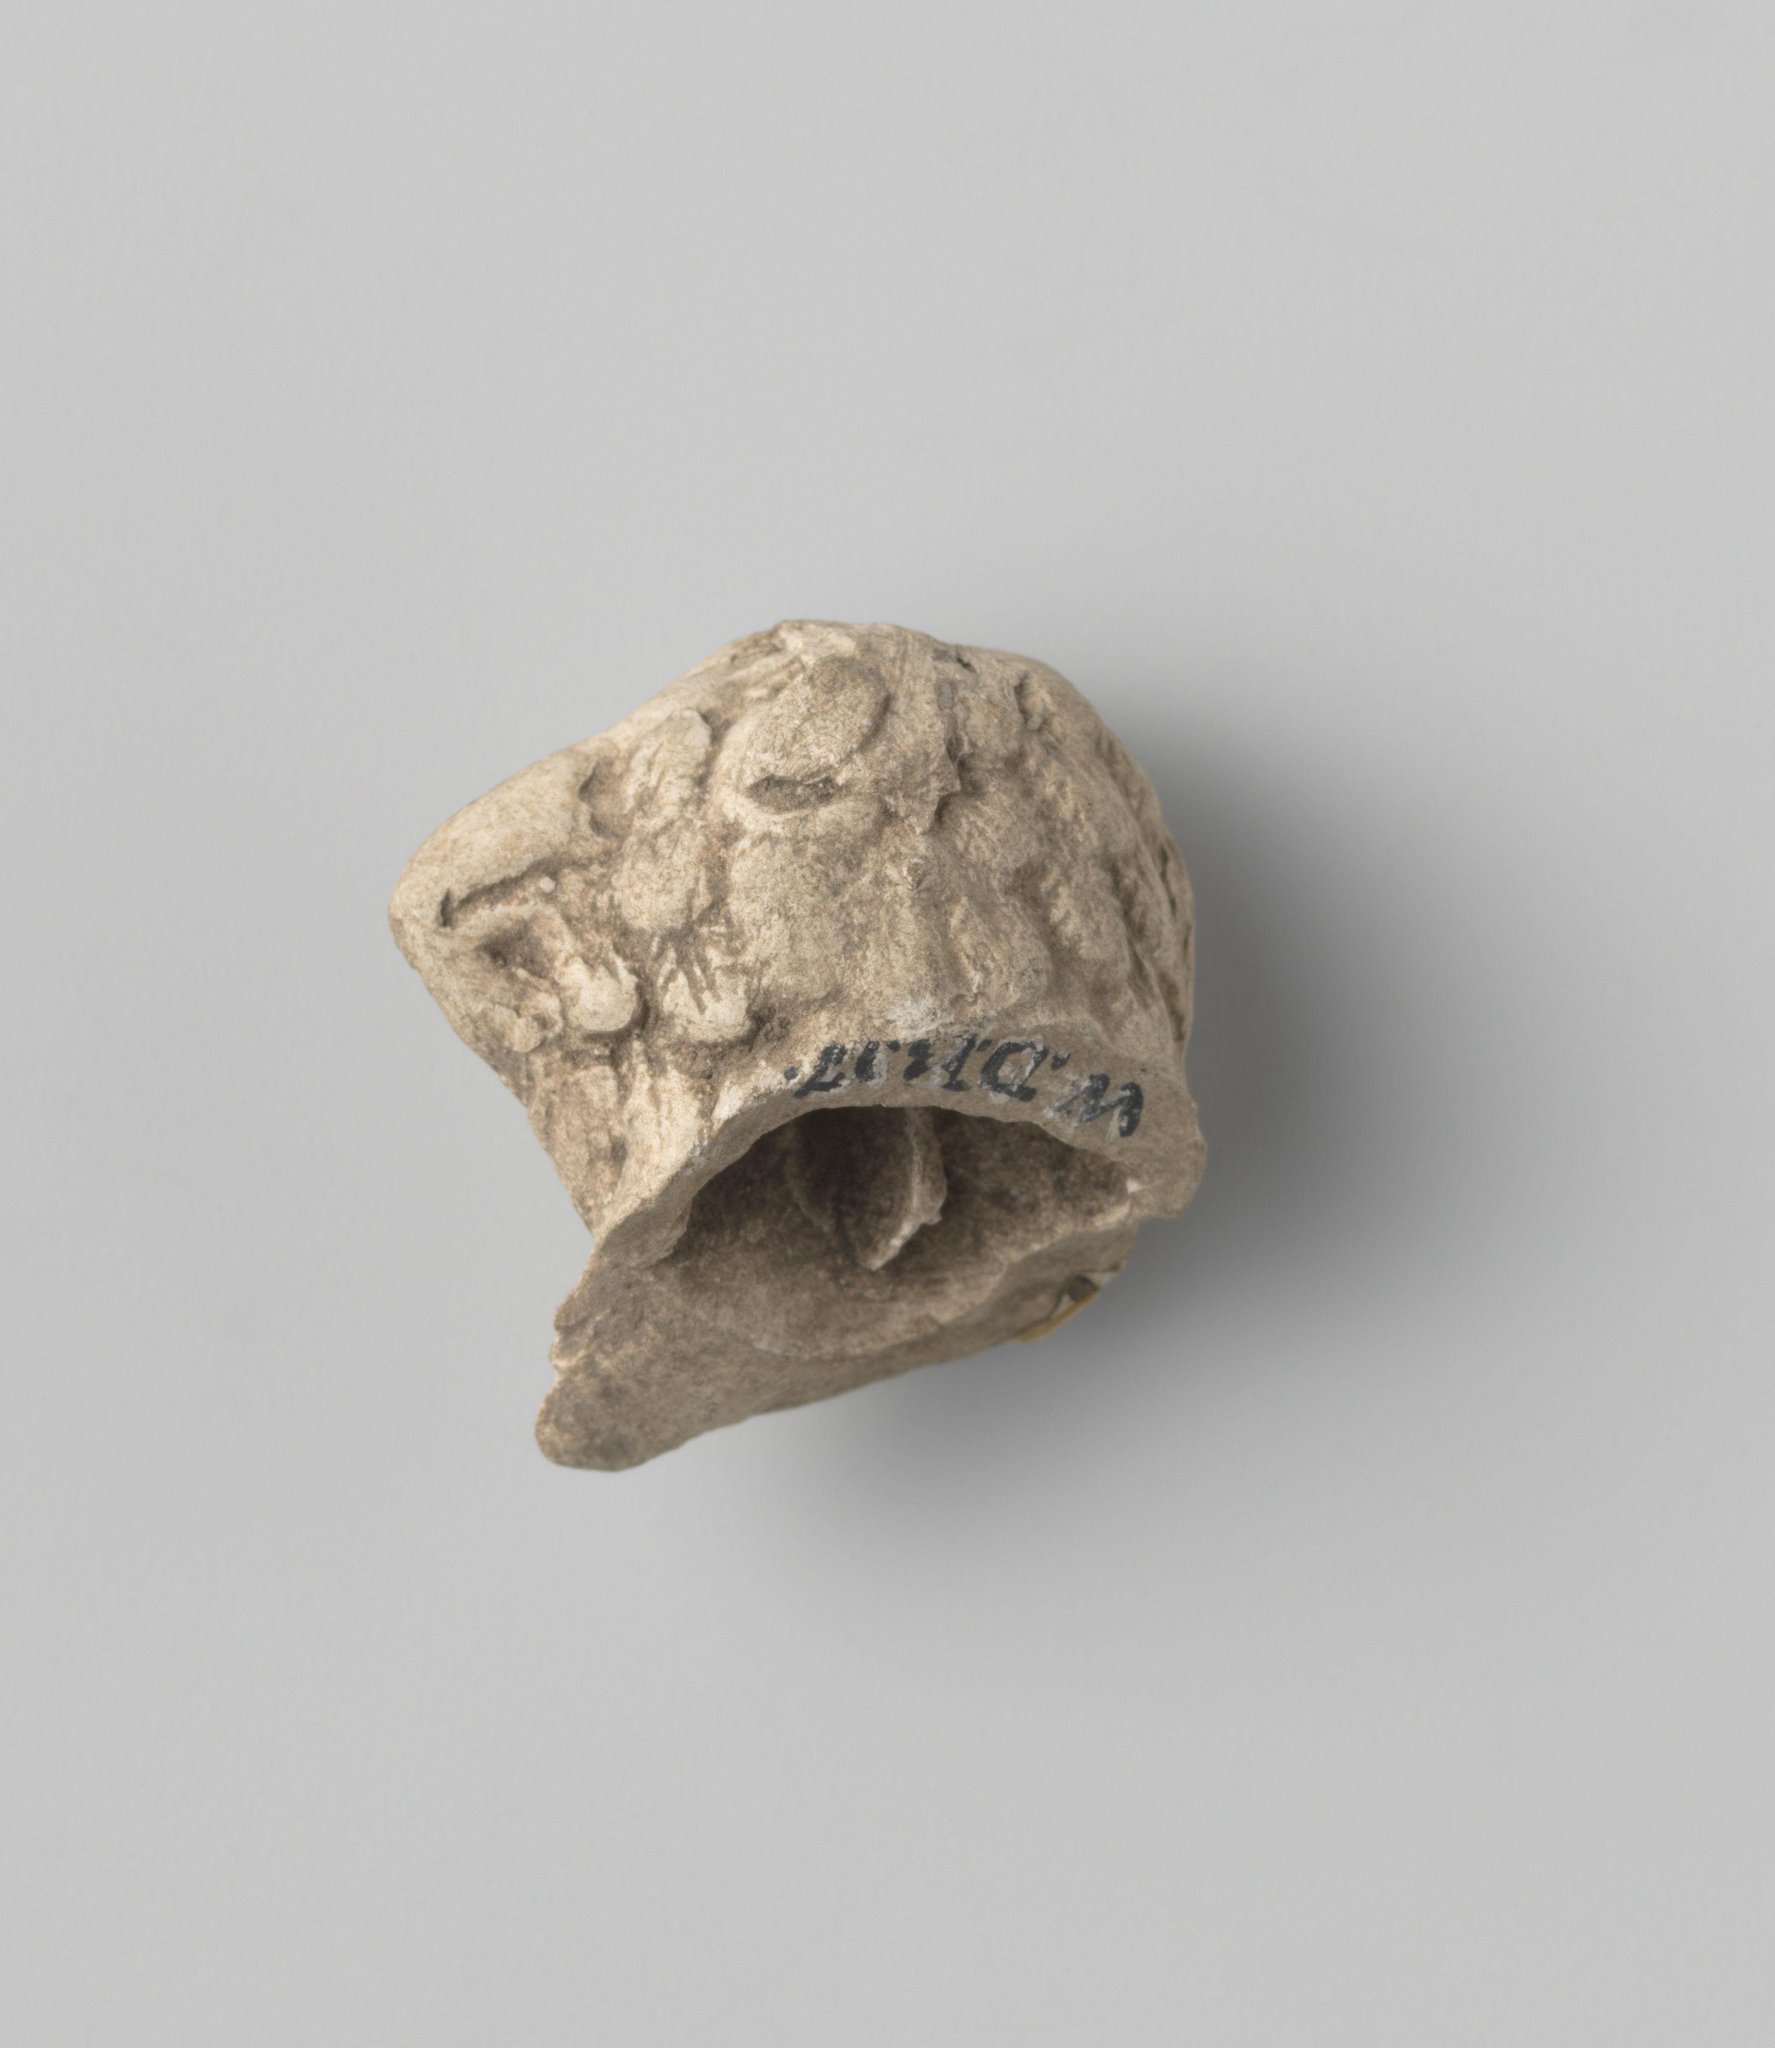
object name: fragment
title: Fragment van een beeldhouwwerk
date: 1400-1950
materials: stone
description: Fragment van een beeldhouwwerk: kop van een vogel.